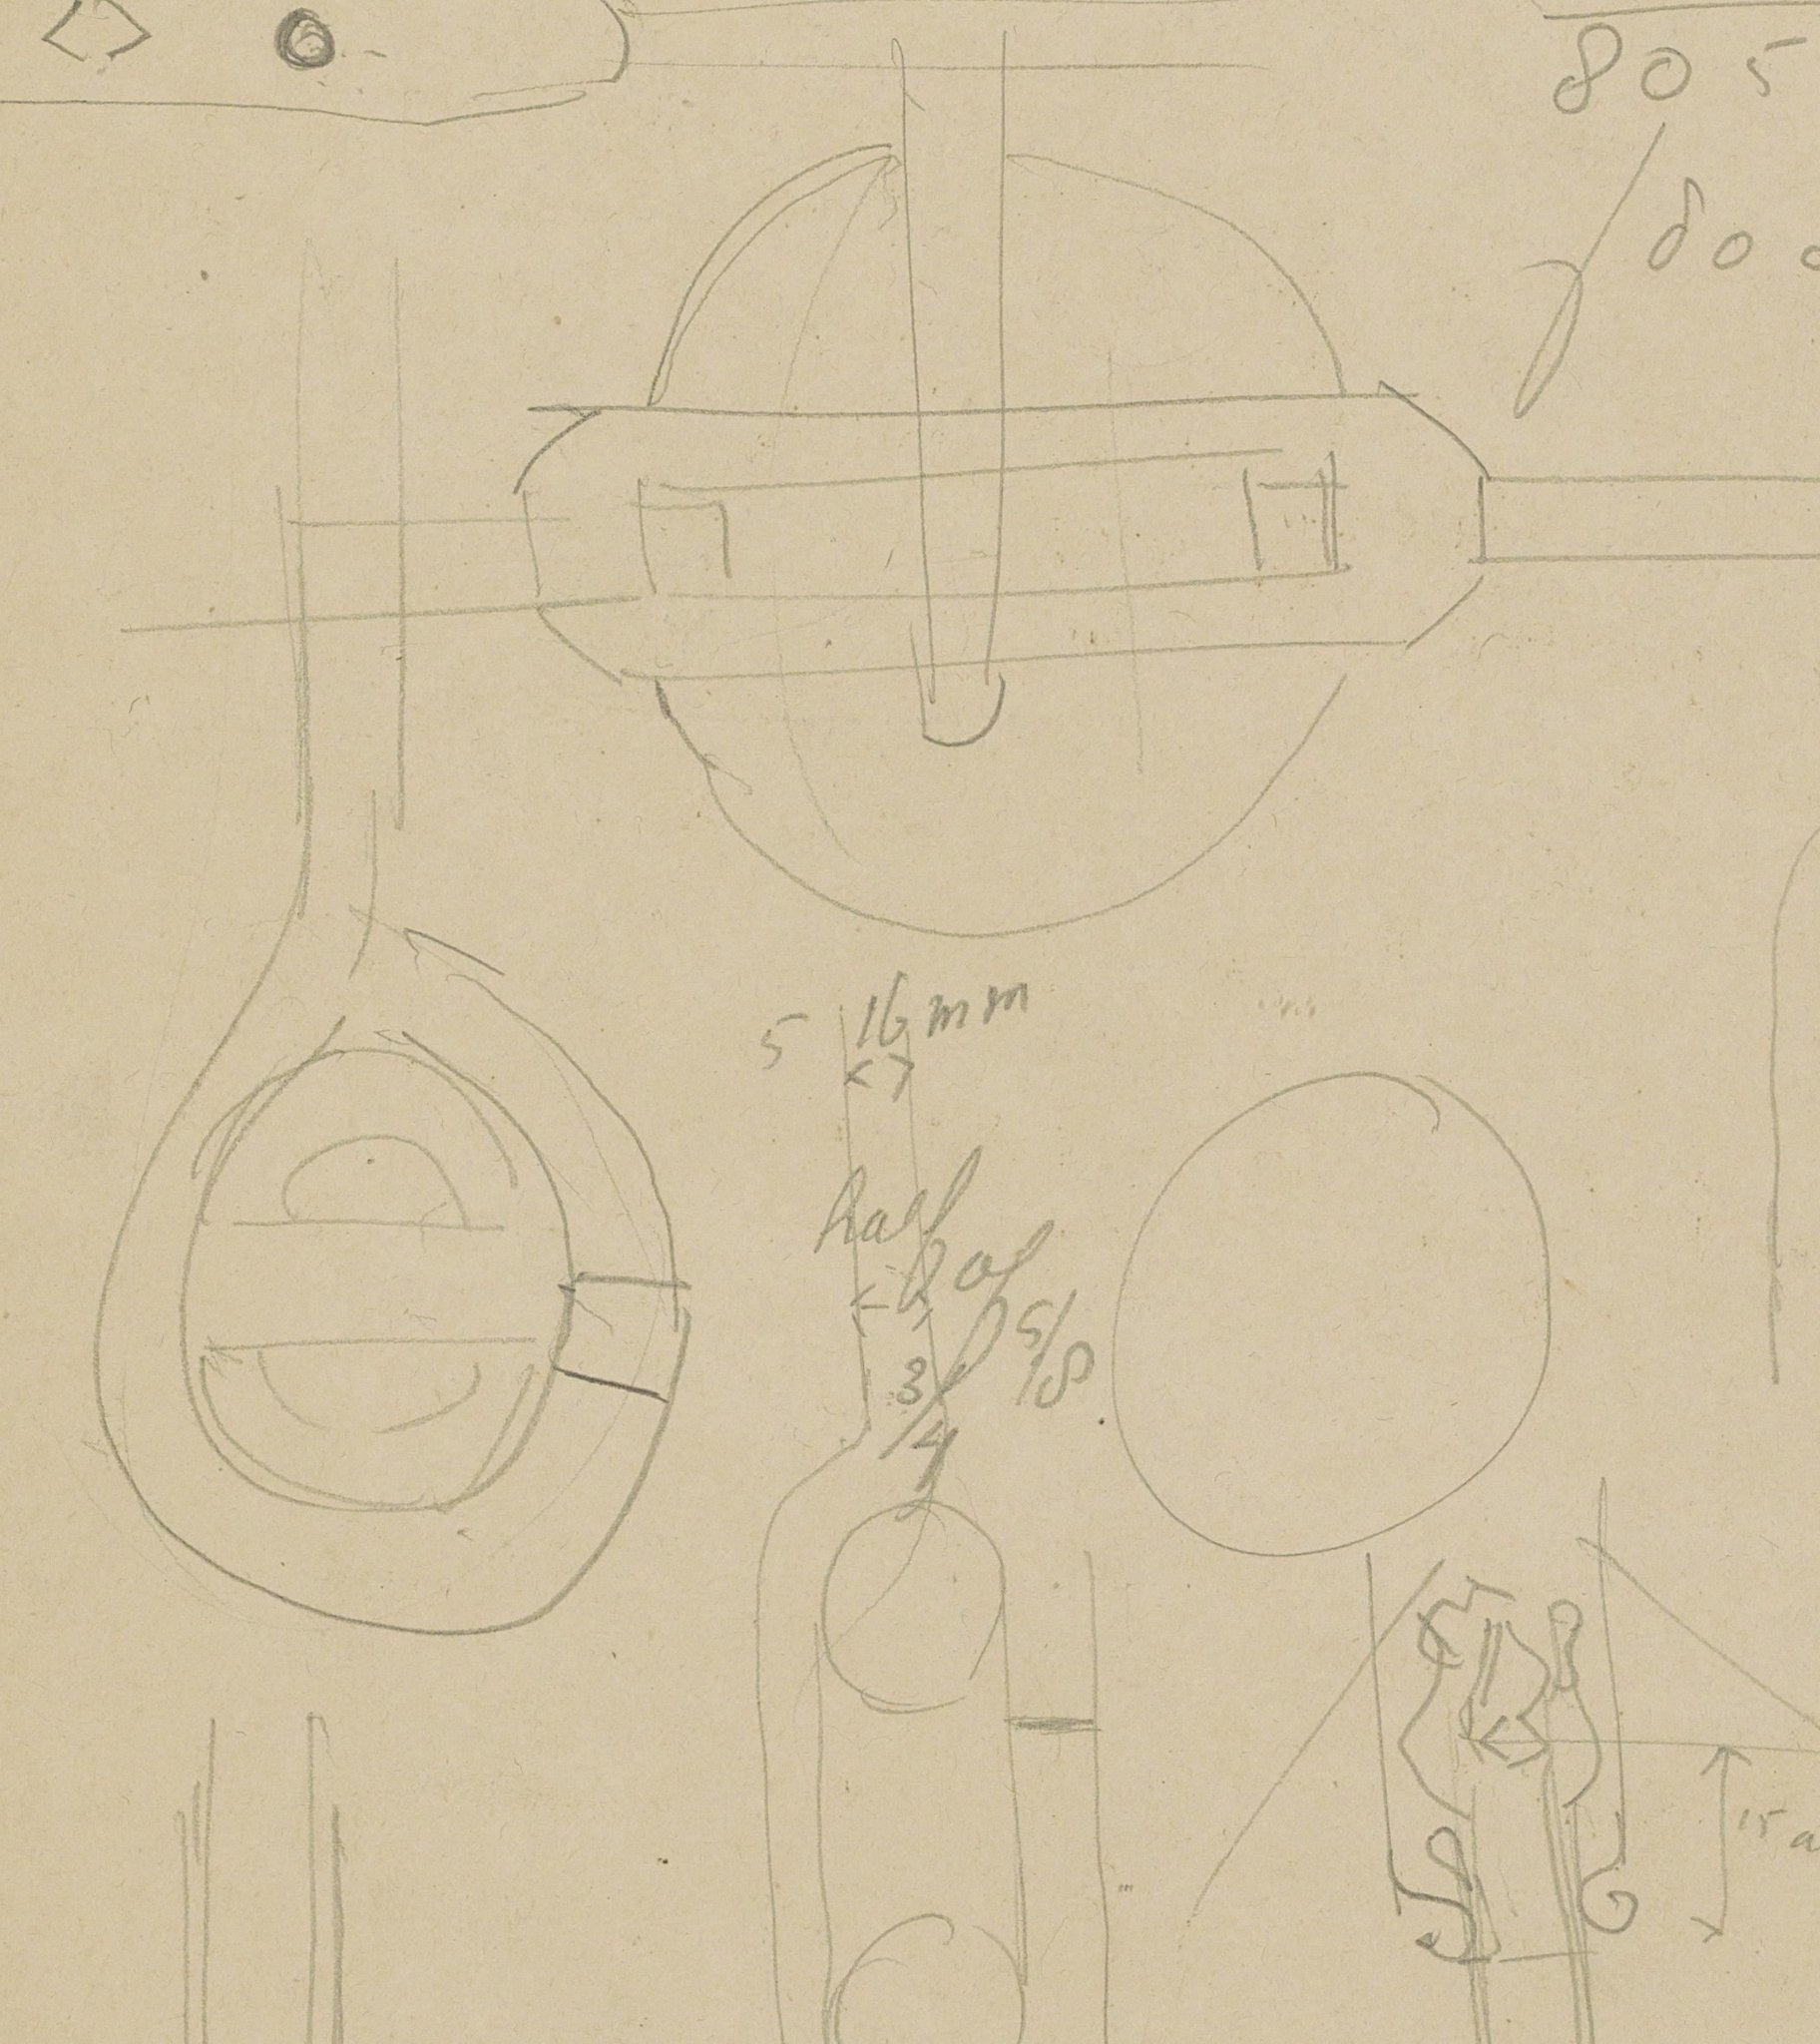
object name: sketchbook leaf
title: Studies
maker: carel adolph lion cachet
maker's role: draughtsman, print maker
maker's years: 1864-1945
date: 1905-1906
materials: paper, pencil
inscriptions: annotation: ‘[...]’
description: Mogelijk architectuurstudies. Blad 7 recto uit een schetsboek met 30 bladen.